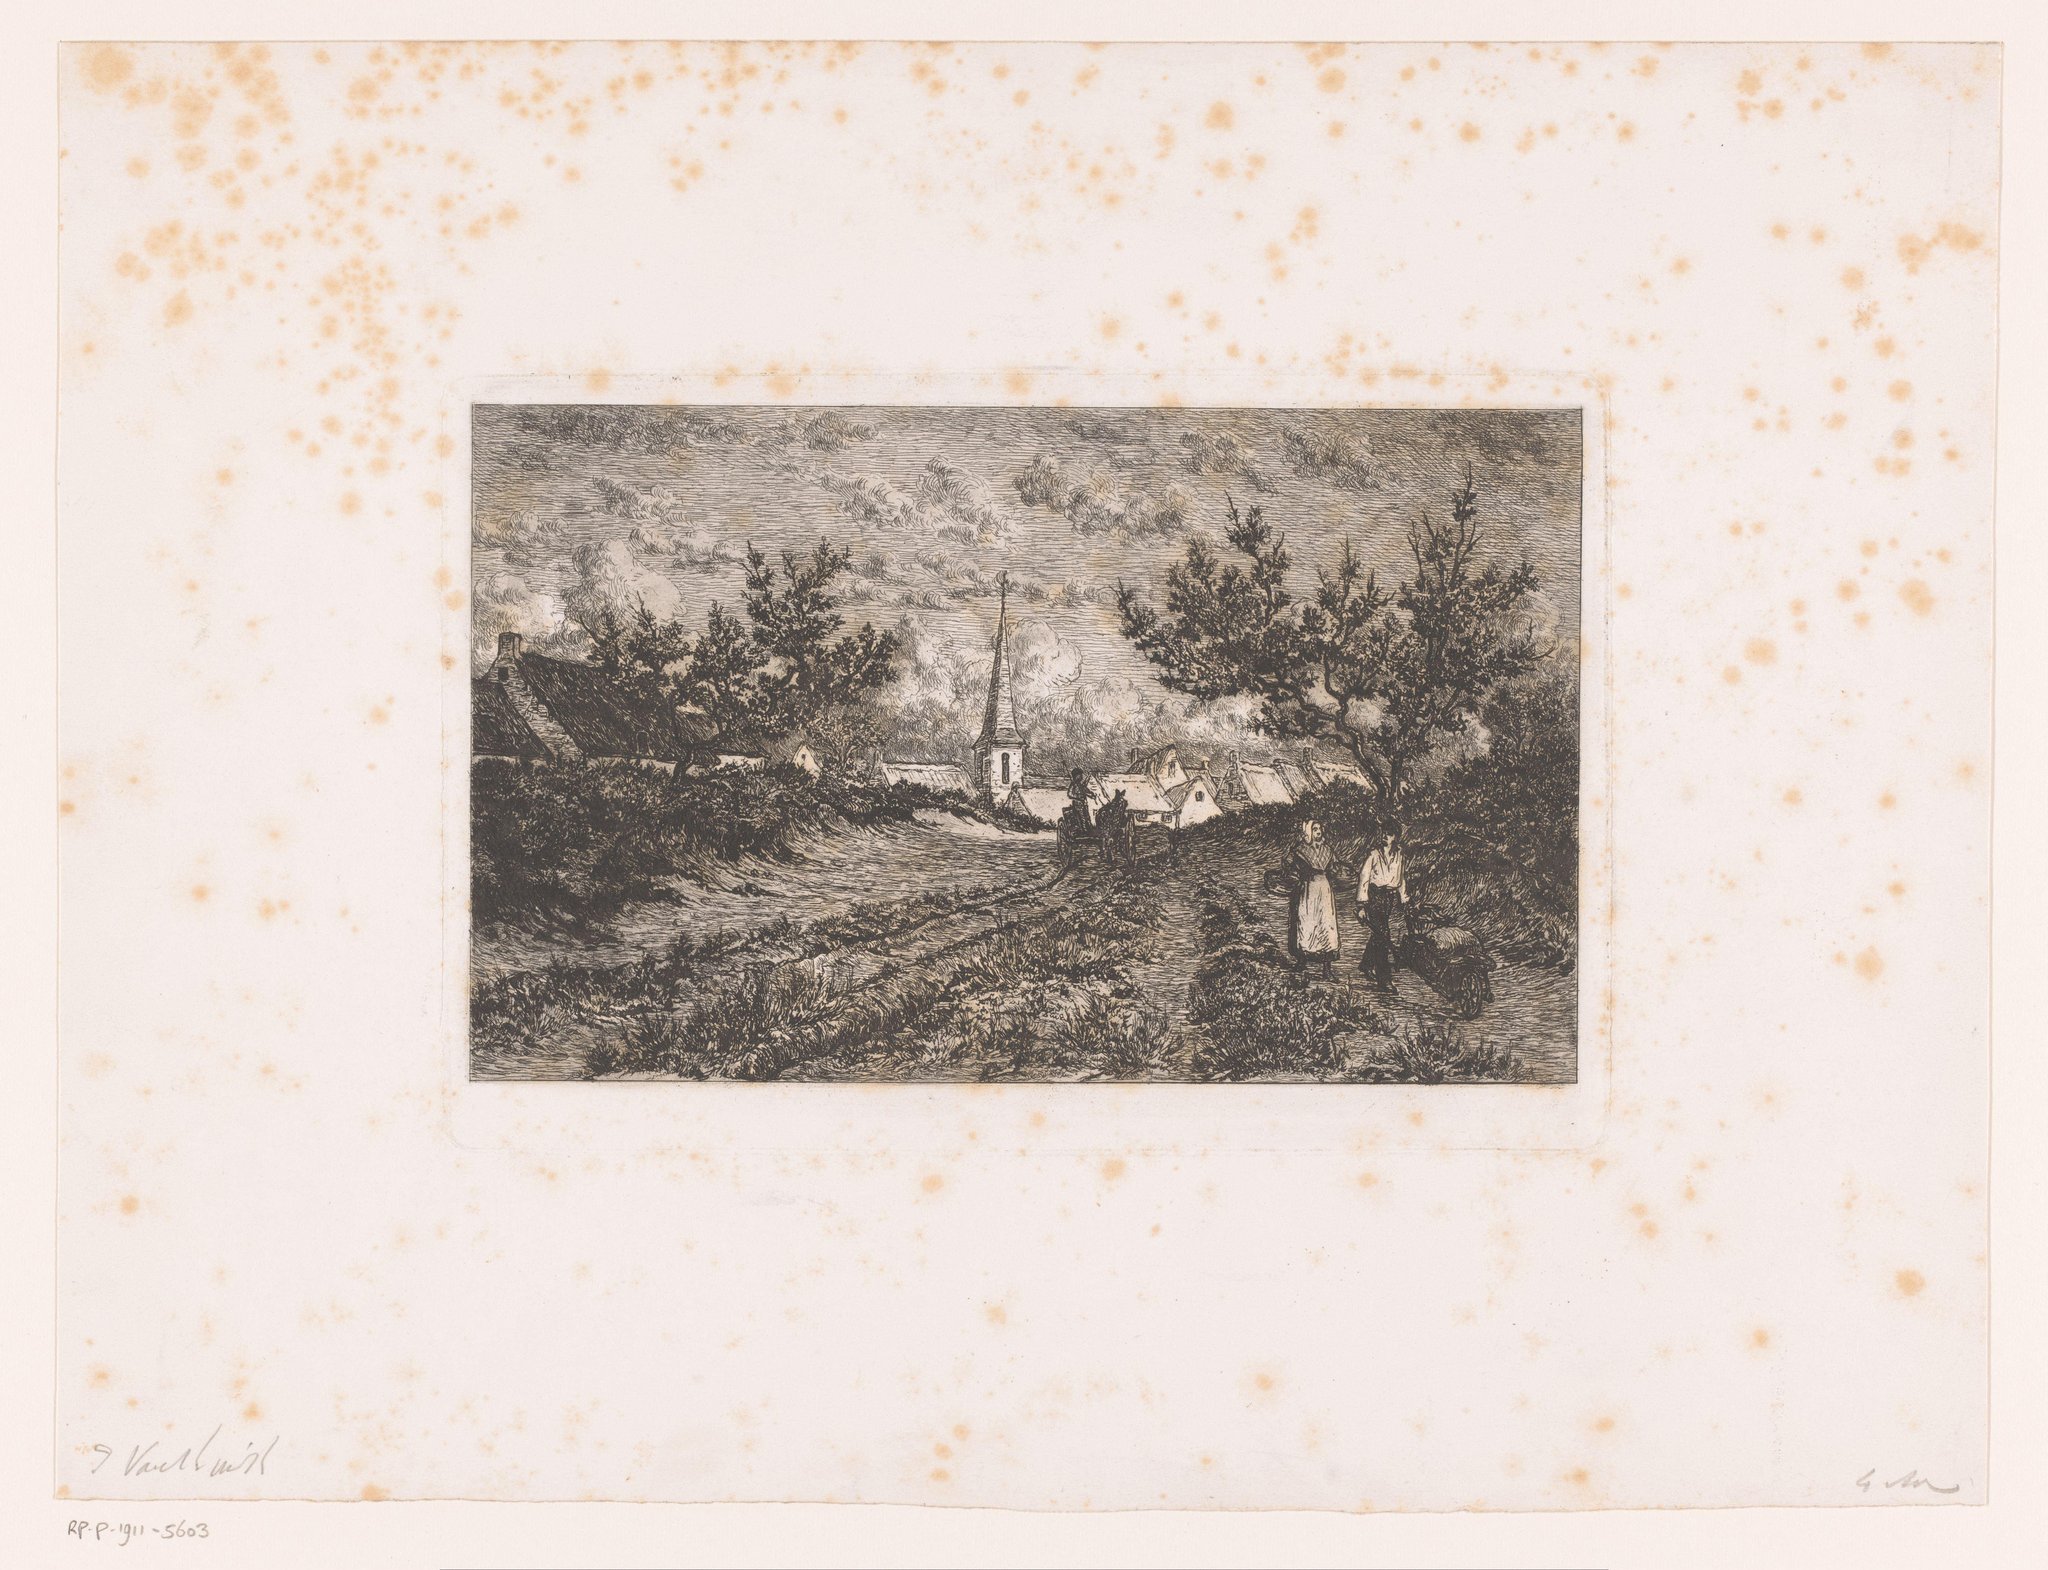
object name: print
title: Dorpsgezicht met landweg in de Kempen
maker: frans van kuyck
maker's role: painter, print maker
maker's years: 1852-1915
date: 1862-1911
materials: paper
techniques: etching, intaglio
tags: prospect of village, silhouette of village, four-wheeled vehicle drawn by one animal, road, path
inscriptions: collector's mark: Lugt 2228